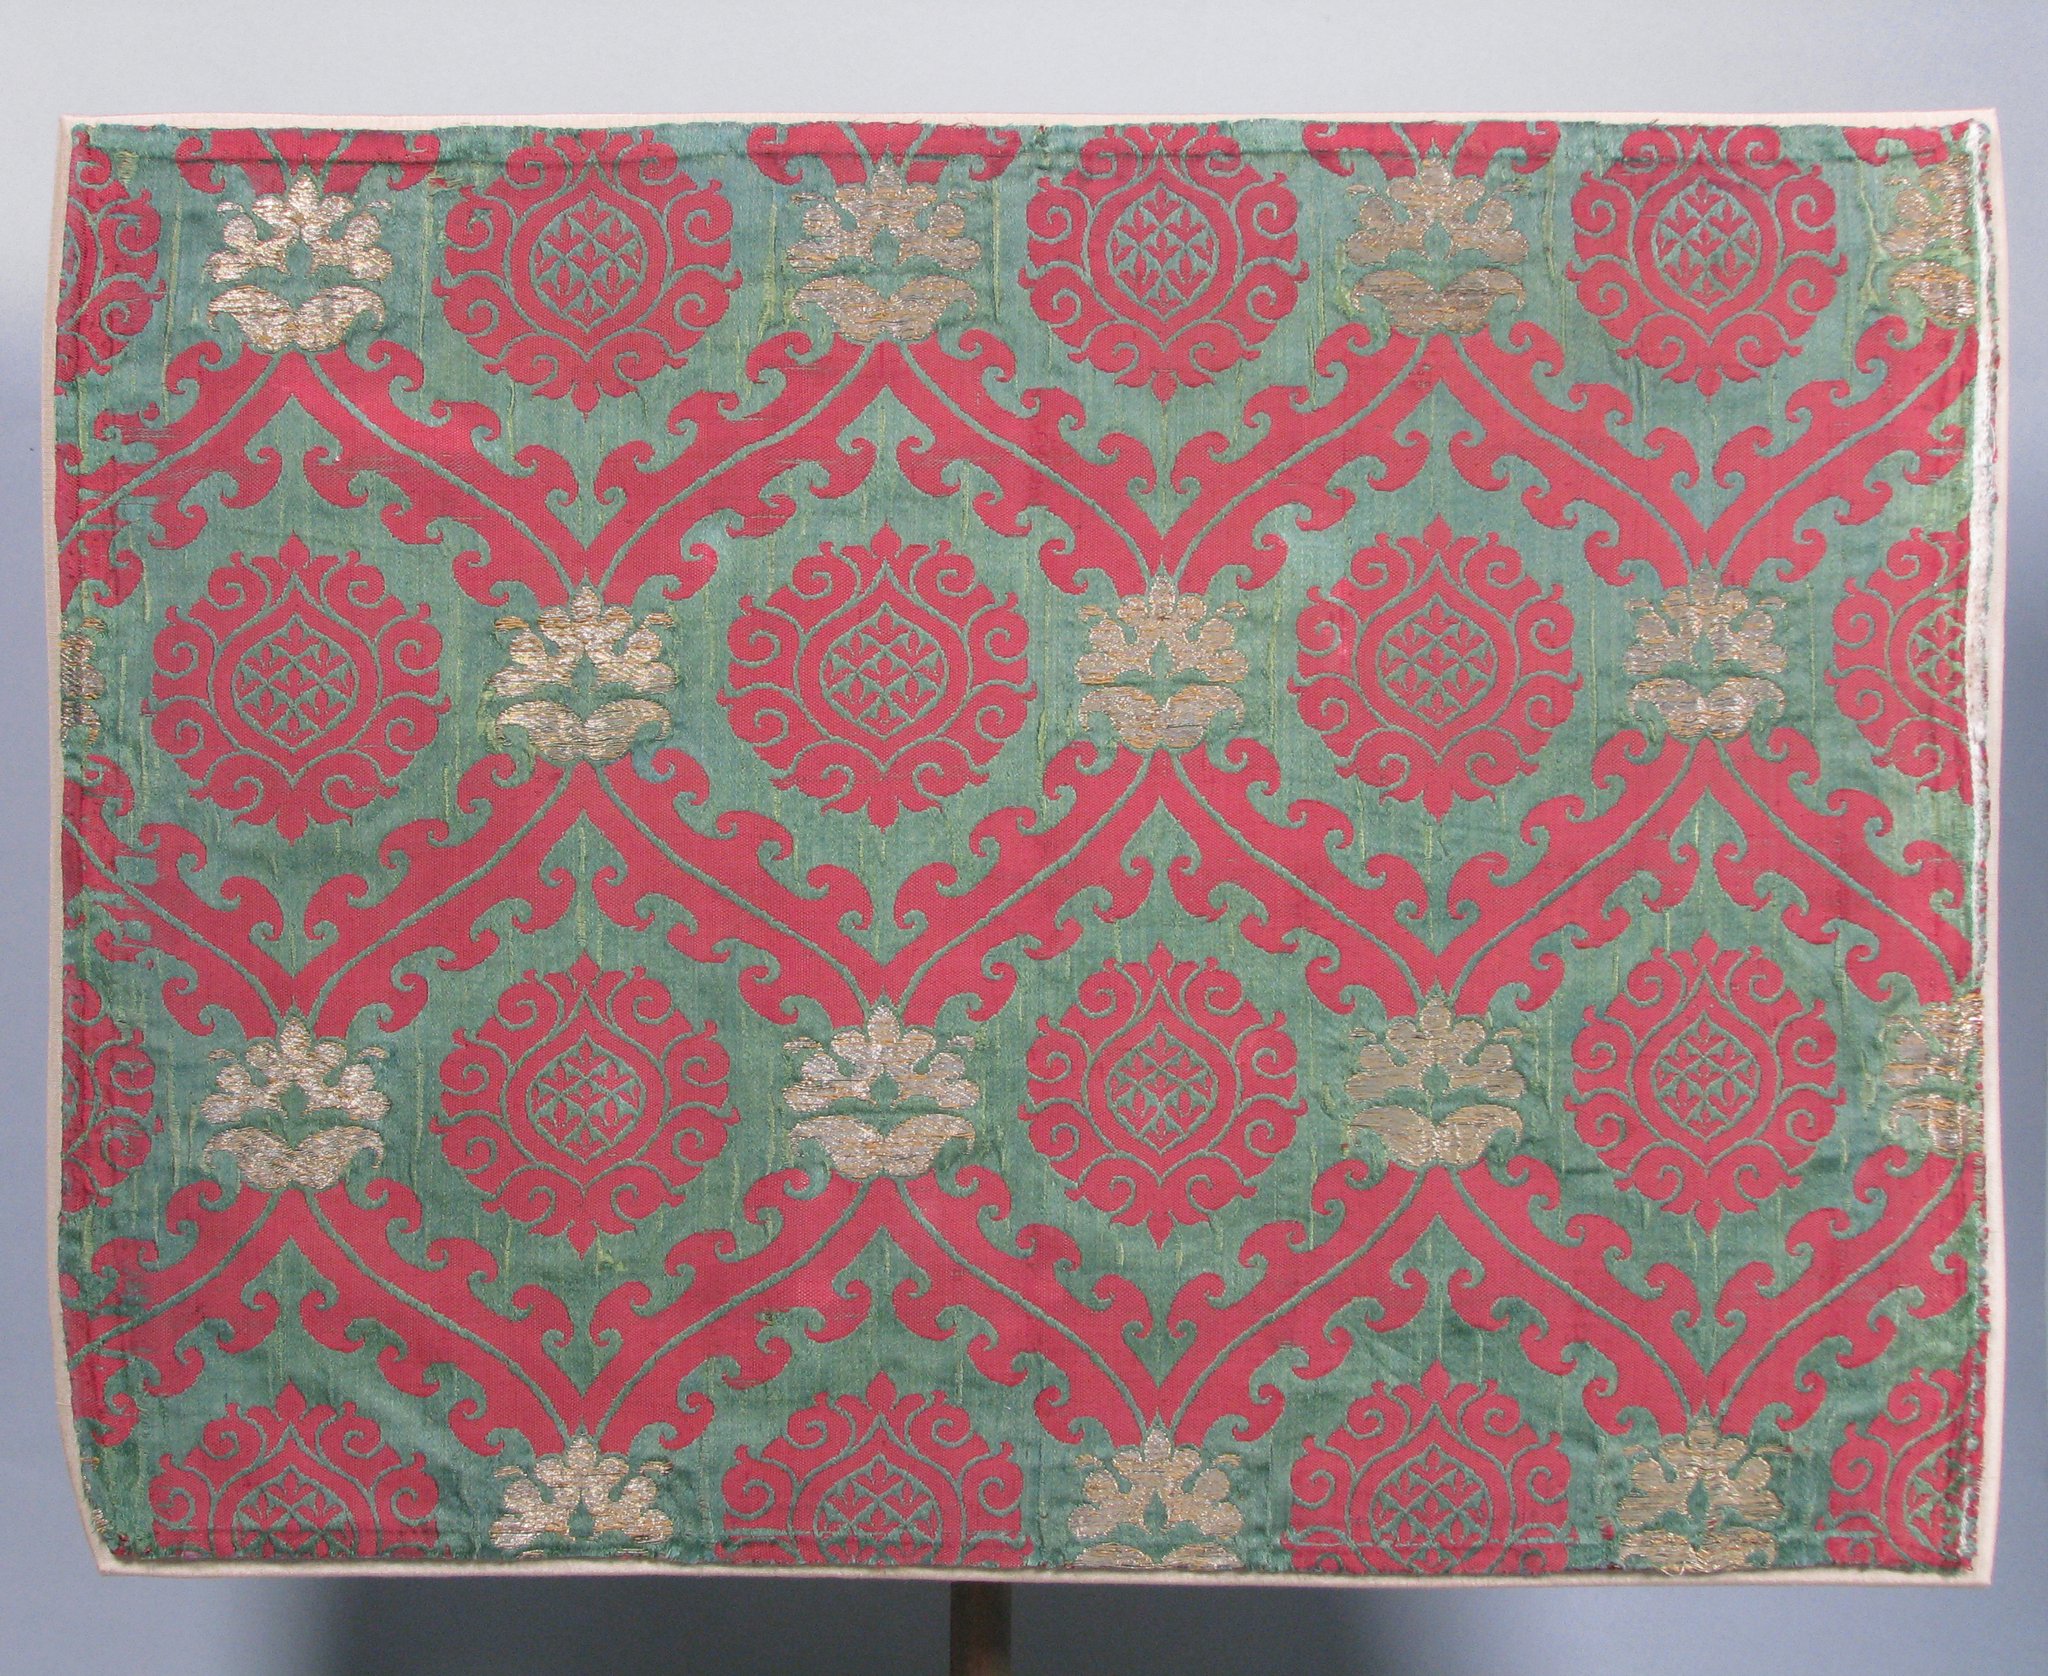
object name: piece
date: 1467-1500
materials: silk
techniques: damask